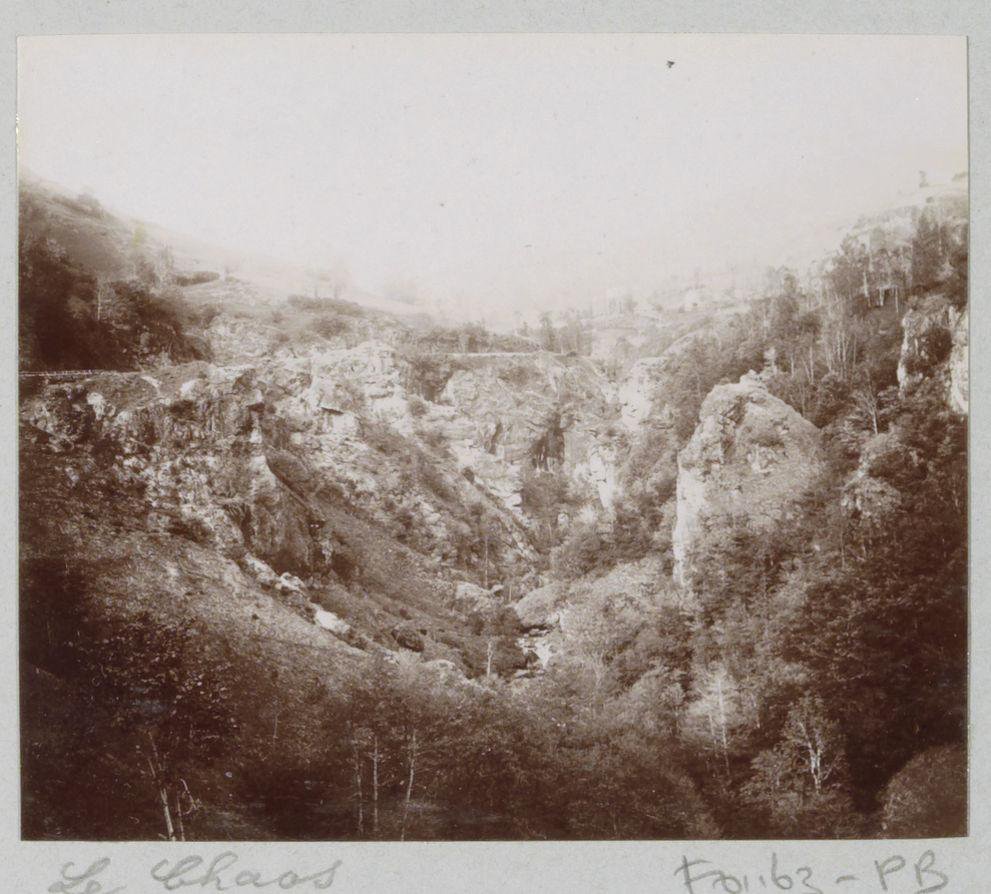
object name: photograph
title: Landschap Le Chaos in de Auvergne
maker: delizy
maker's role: manufacturer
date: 1902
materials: paper, photographic support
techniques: gelatin silver print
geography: auvergne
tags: mountains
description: Onderdeel van Fotoalbum van een Franse amateurfotograaf met opnames van uitstapjes in Frankrijk, Spanje, België, Luxemburg en Nederland, de eerste automobielen en autoraces.